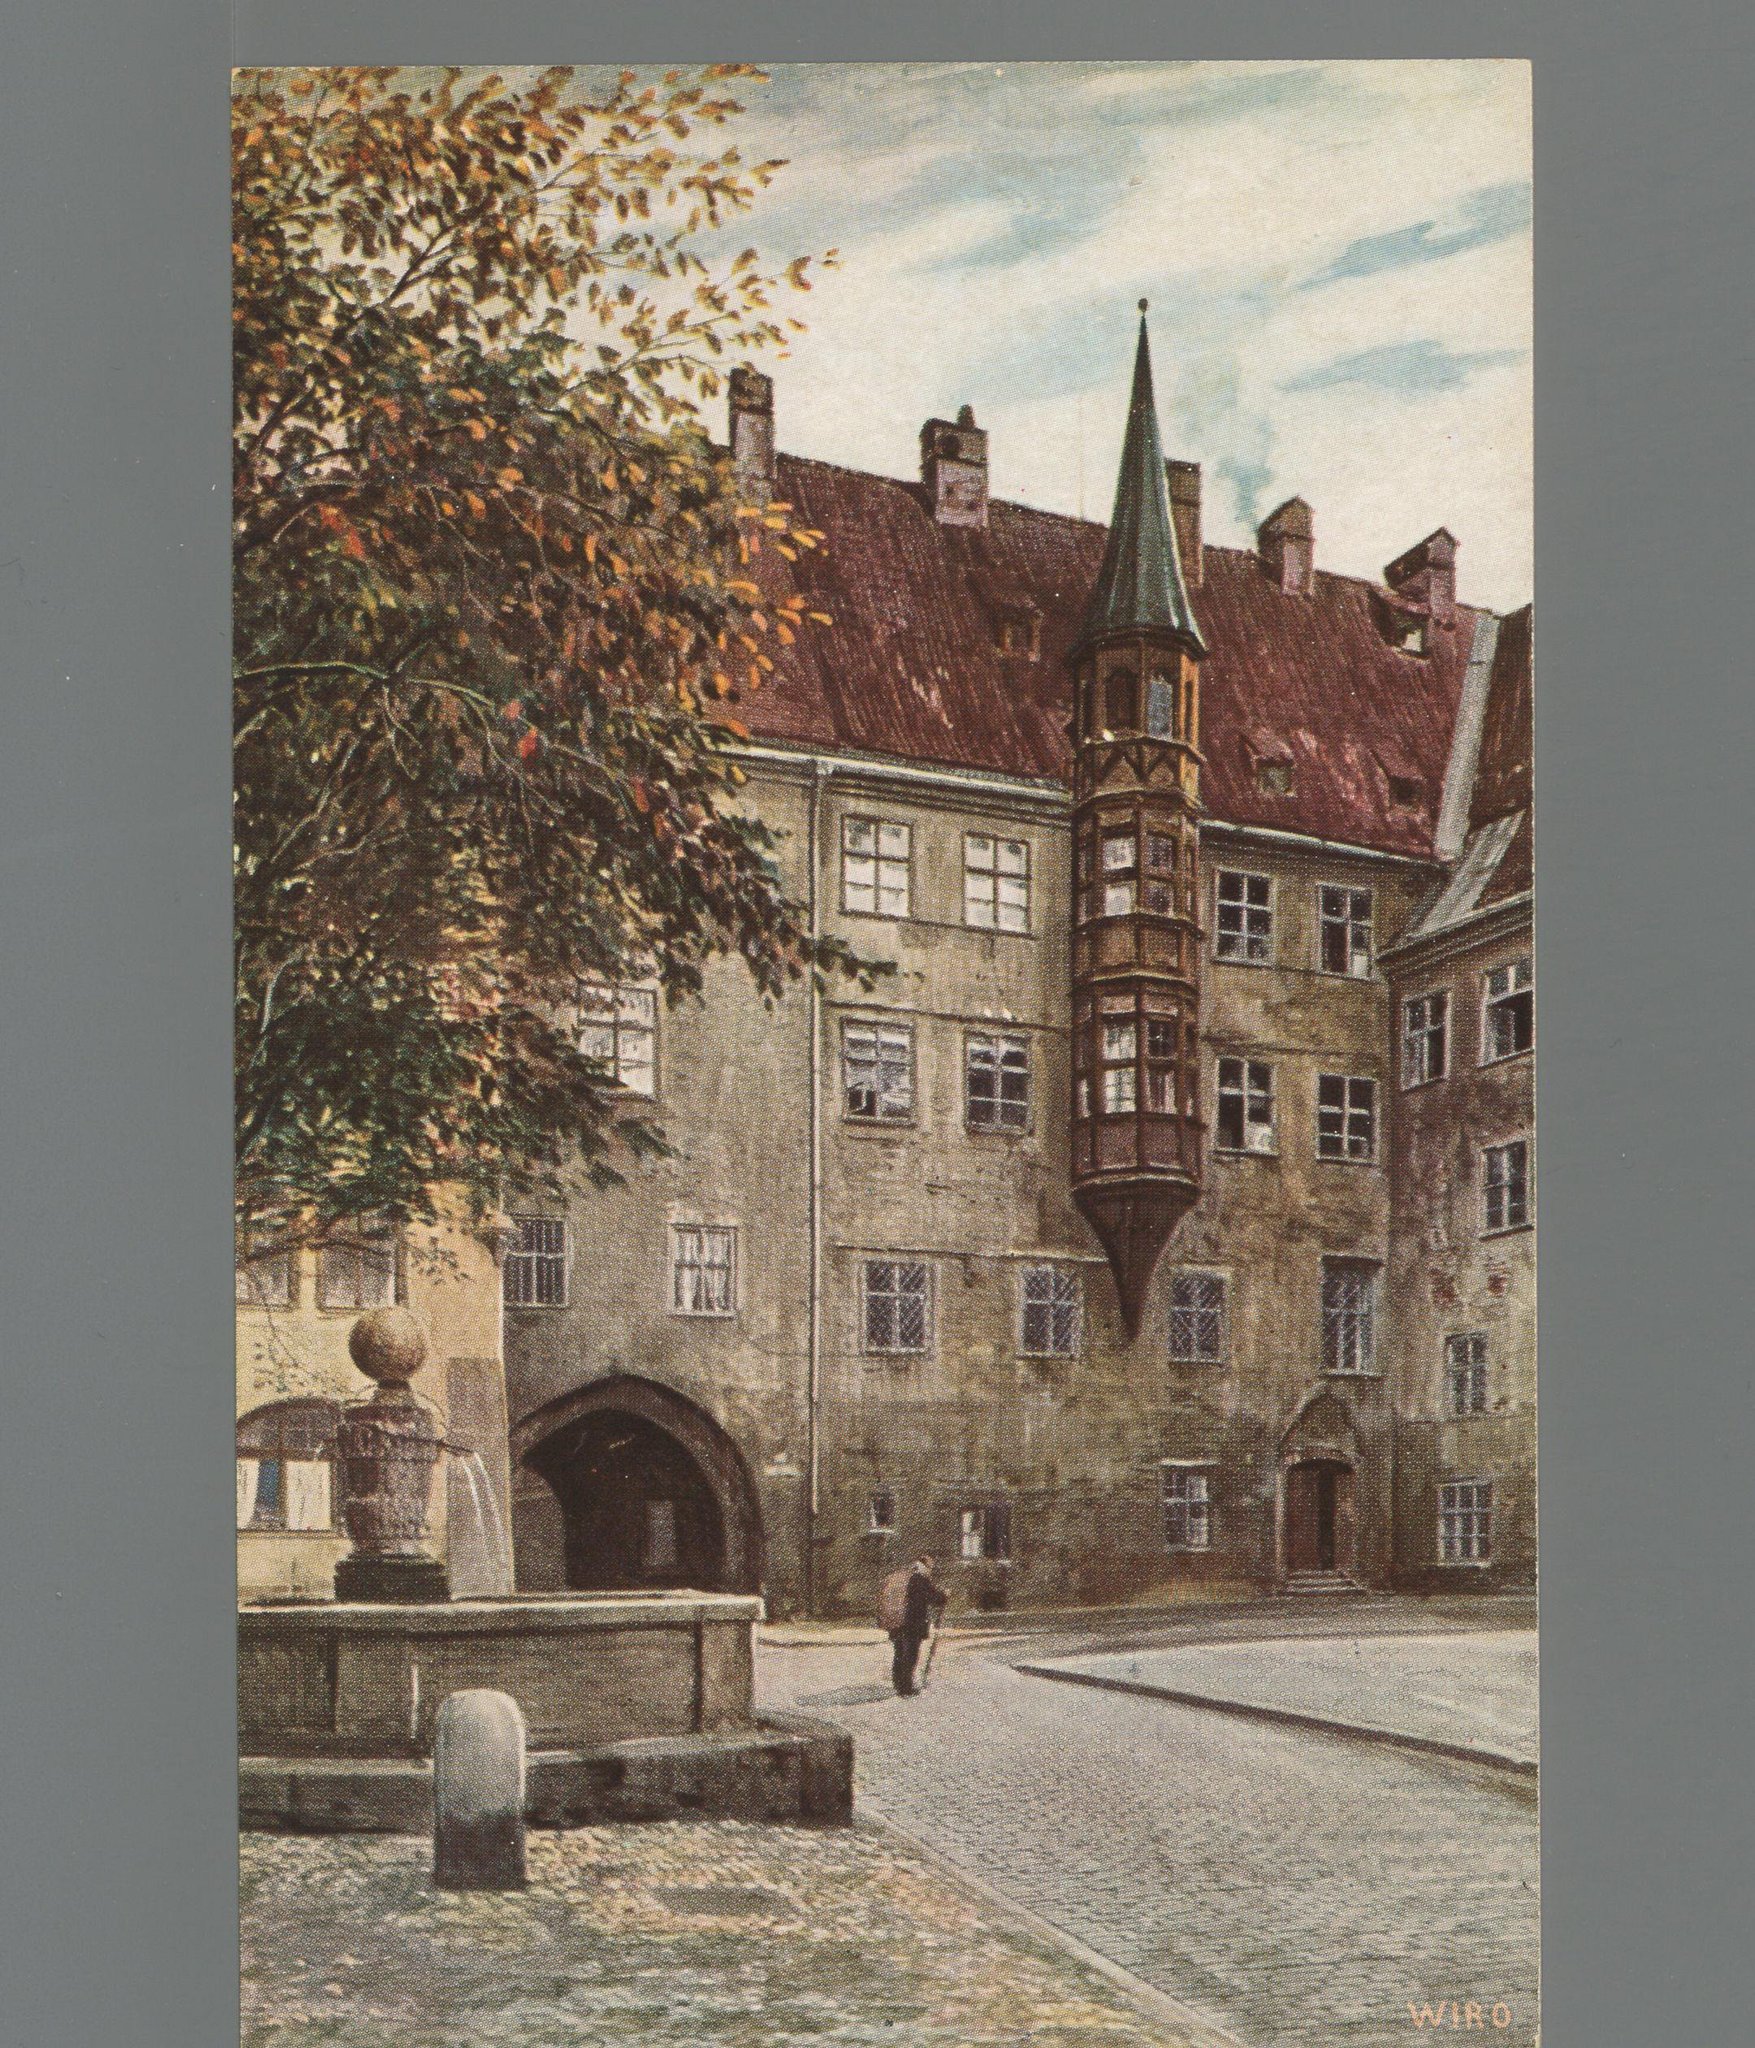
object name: photomechanical print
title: Künstler-Serie "WIRO" München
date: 1905-1930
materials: cardboard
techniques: color autotype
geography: munich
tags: palace